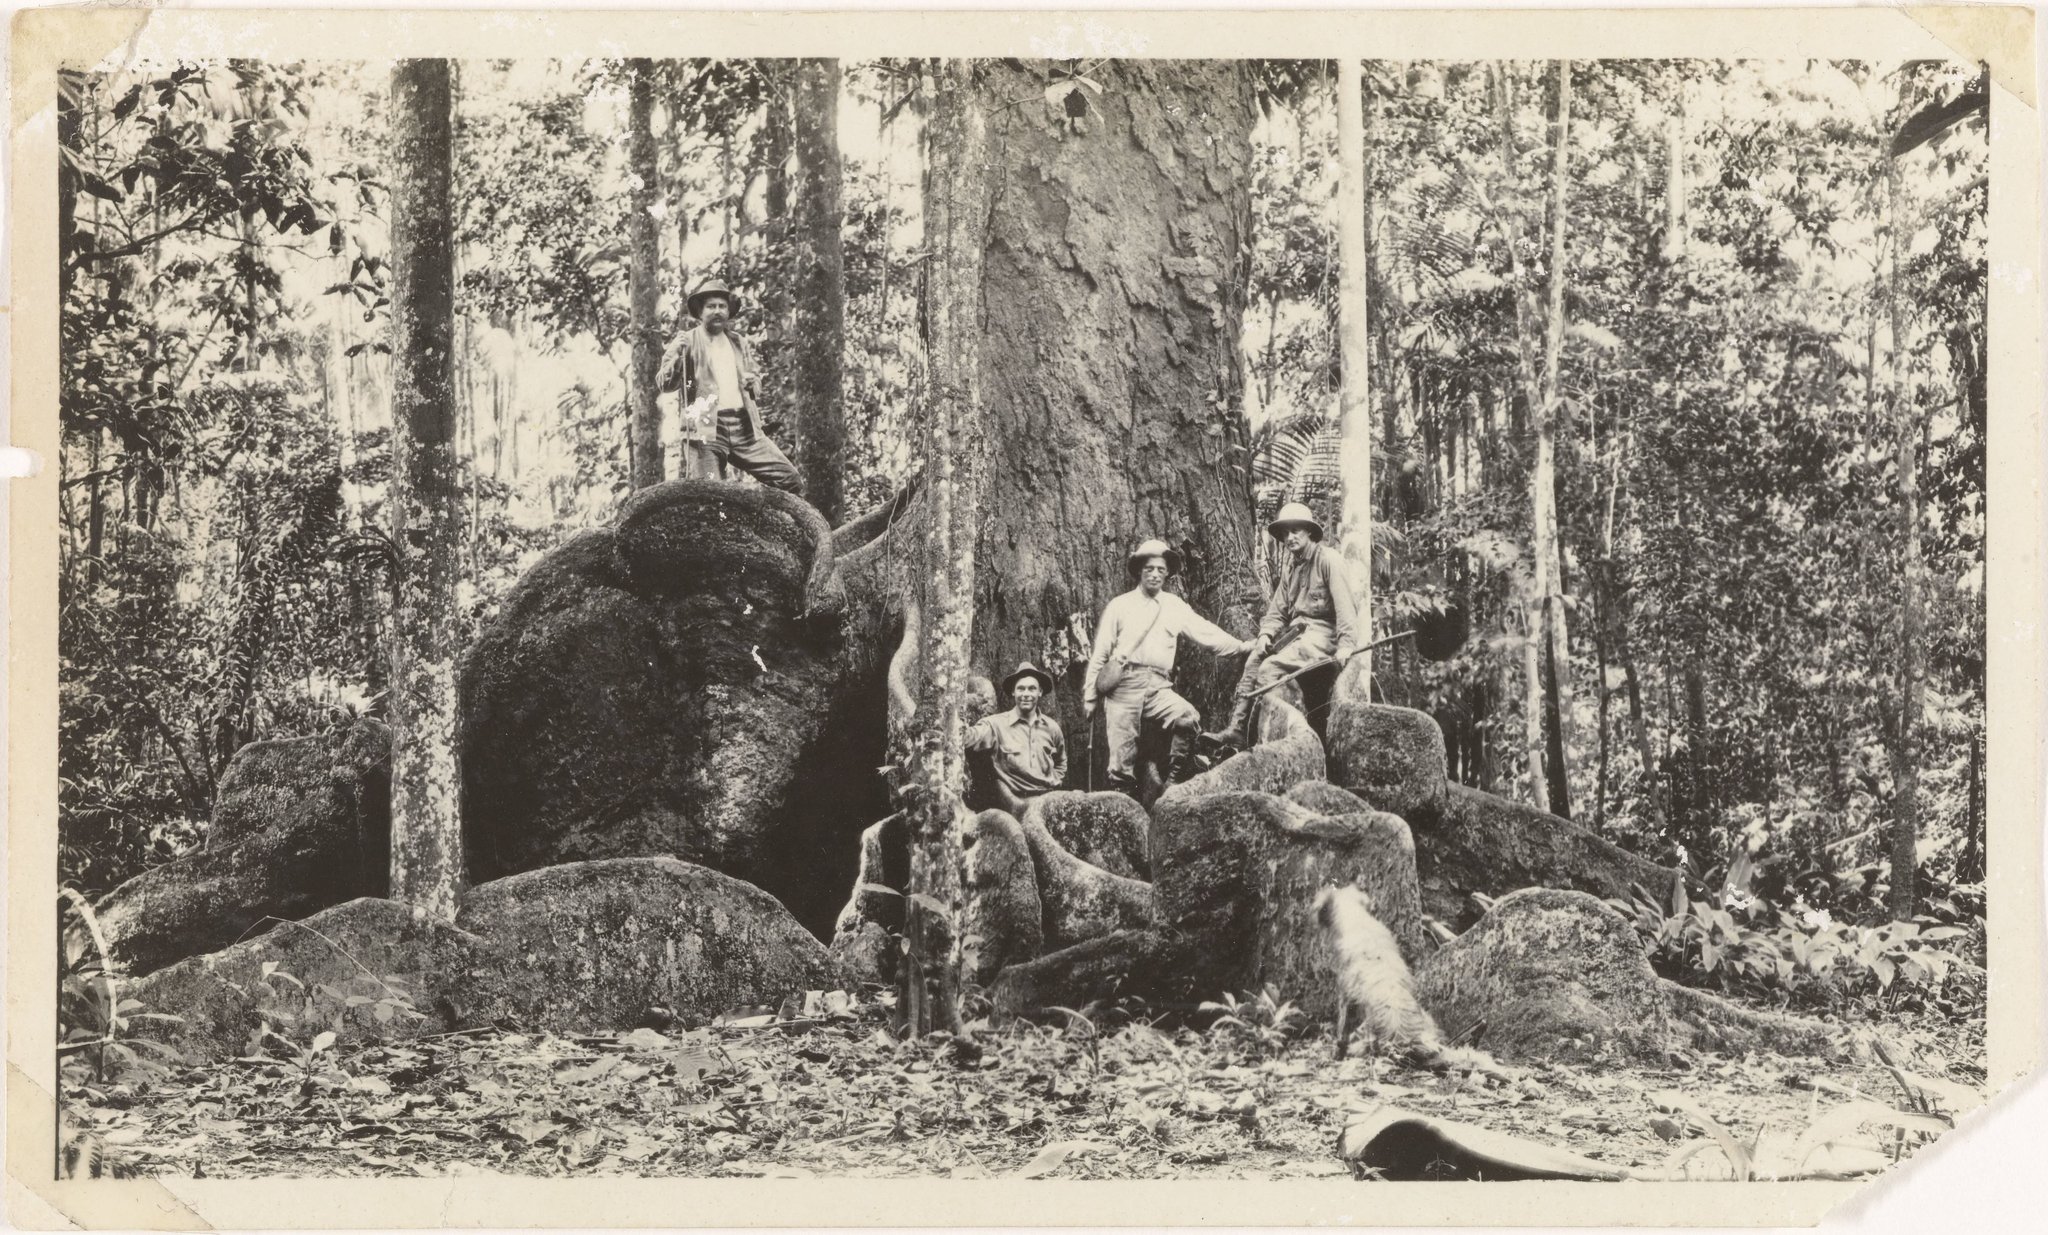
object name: photograph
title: Jachtgezelschap bij boom op plantage Accaribo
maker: Anonymous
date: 1911-1932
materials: photographic support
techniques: photography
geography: suriname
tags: amsterdam, theodoor brouwers, suriname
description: In de periode 1911-1932 woonde op plantage Accaribo in Suriname de familie Brouwers van wie de foto's afkomstig zijn. Rond 1910 vond Theodoor Brouwers werk op plantage Accaribo. In 1929 werd hij eigenaar van de plantage.